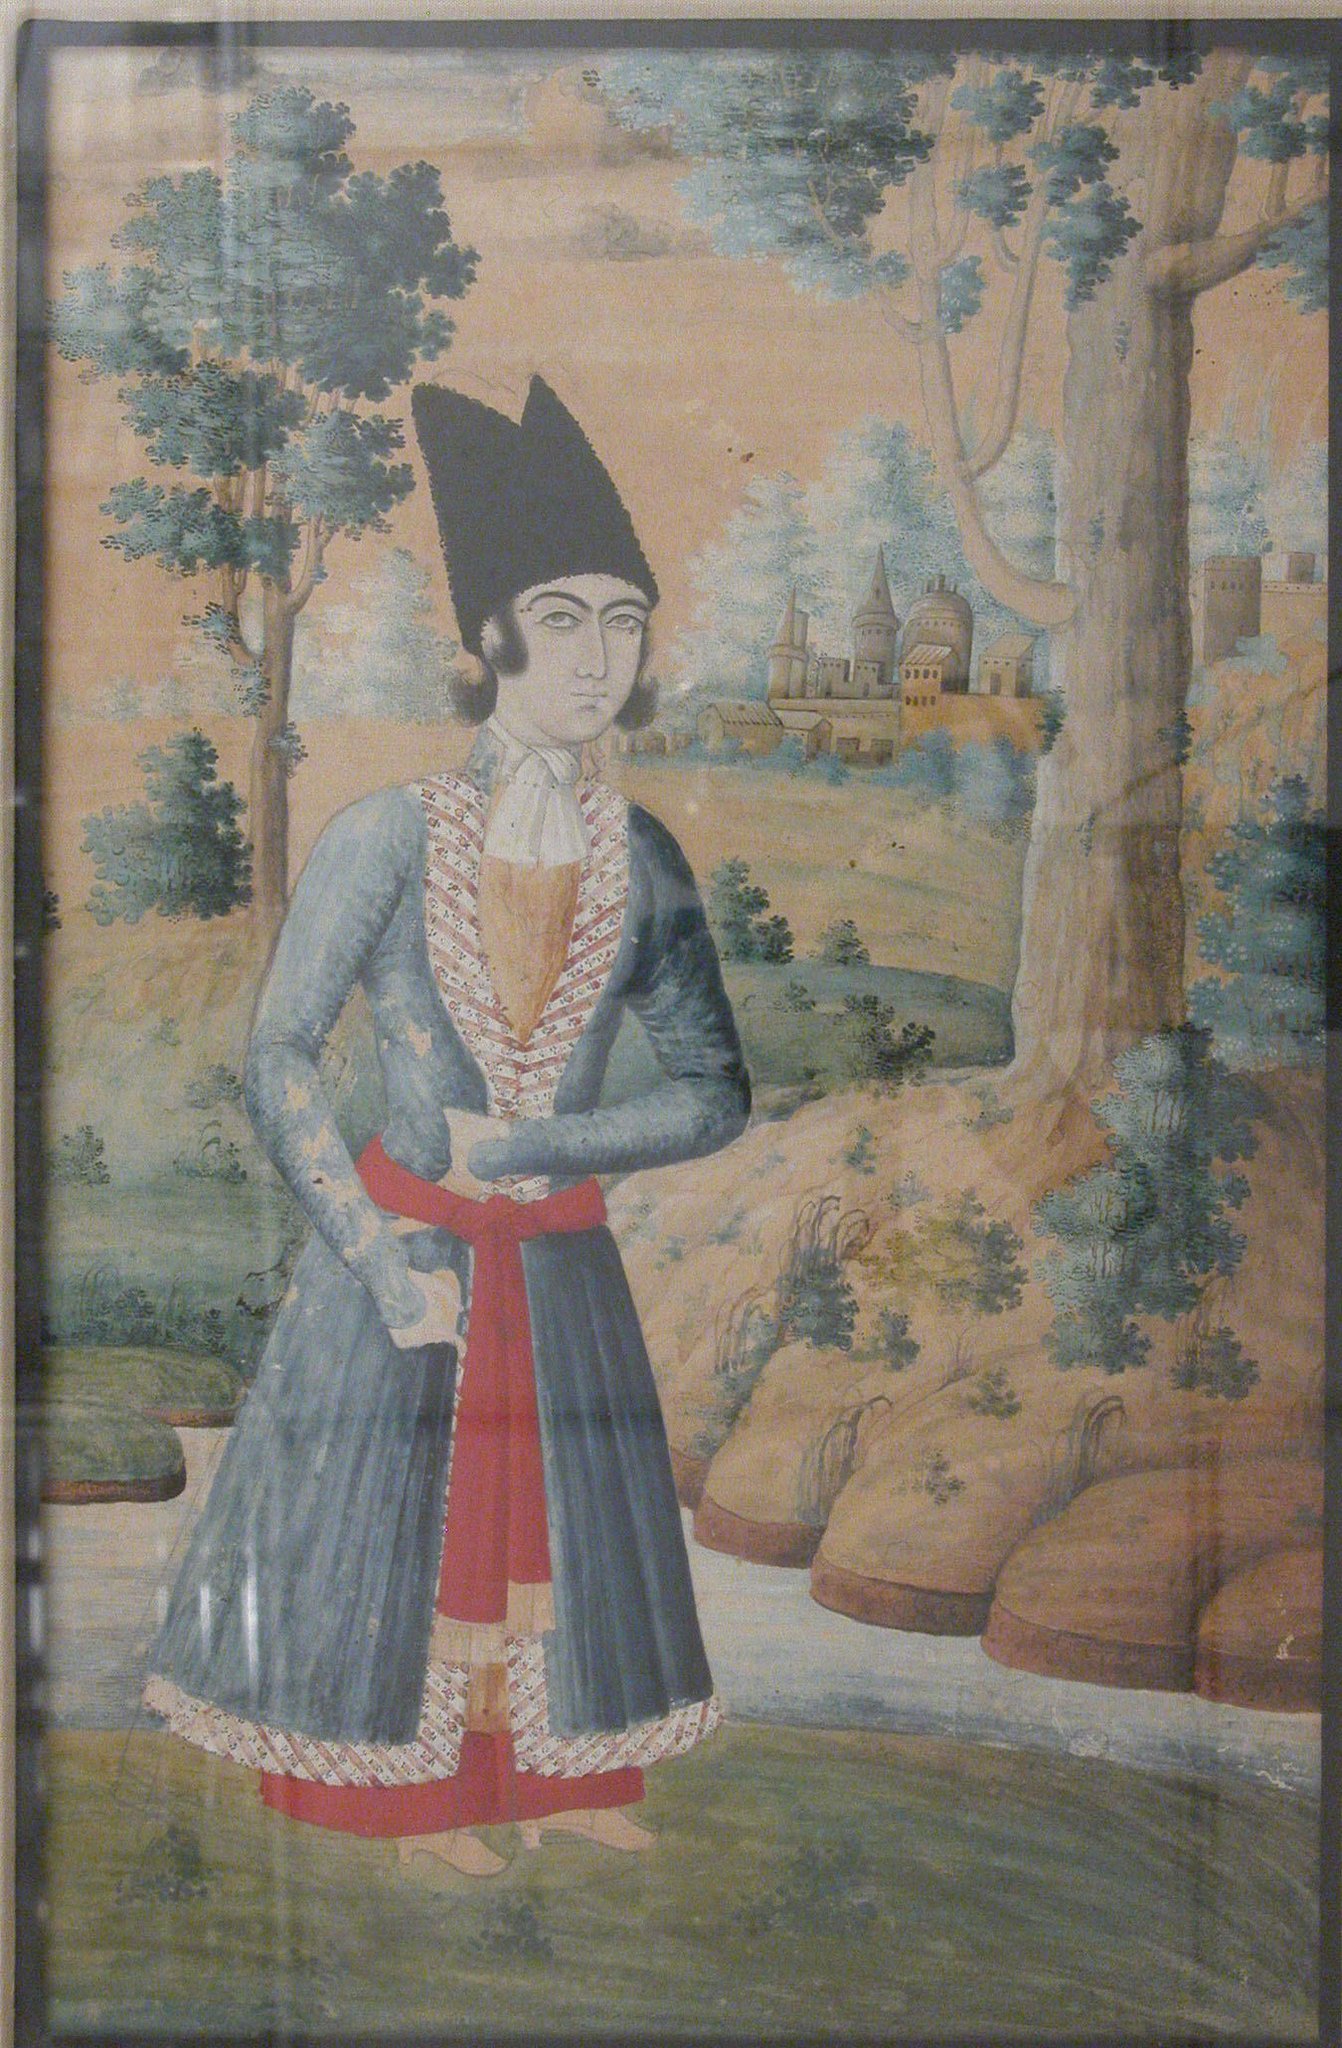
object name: illustrated single work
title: Portrait of a Prince in Italianate Landscape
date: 1801-1833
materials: paper, watercolor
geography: iran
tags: princes,men,portraits